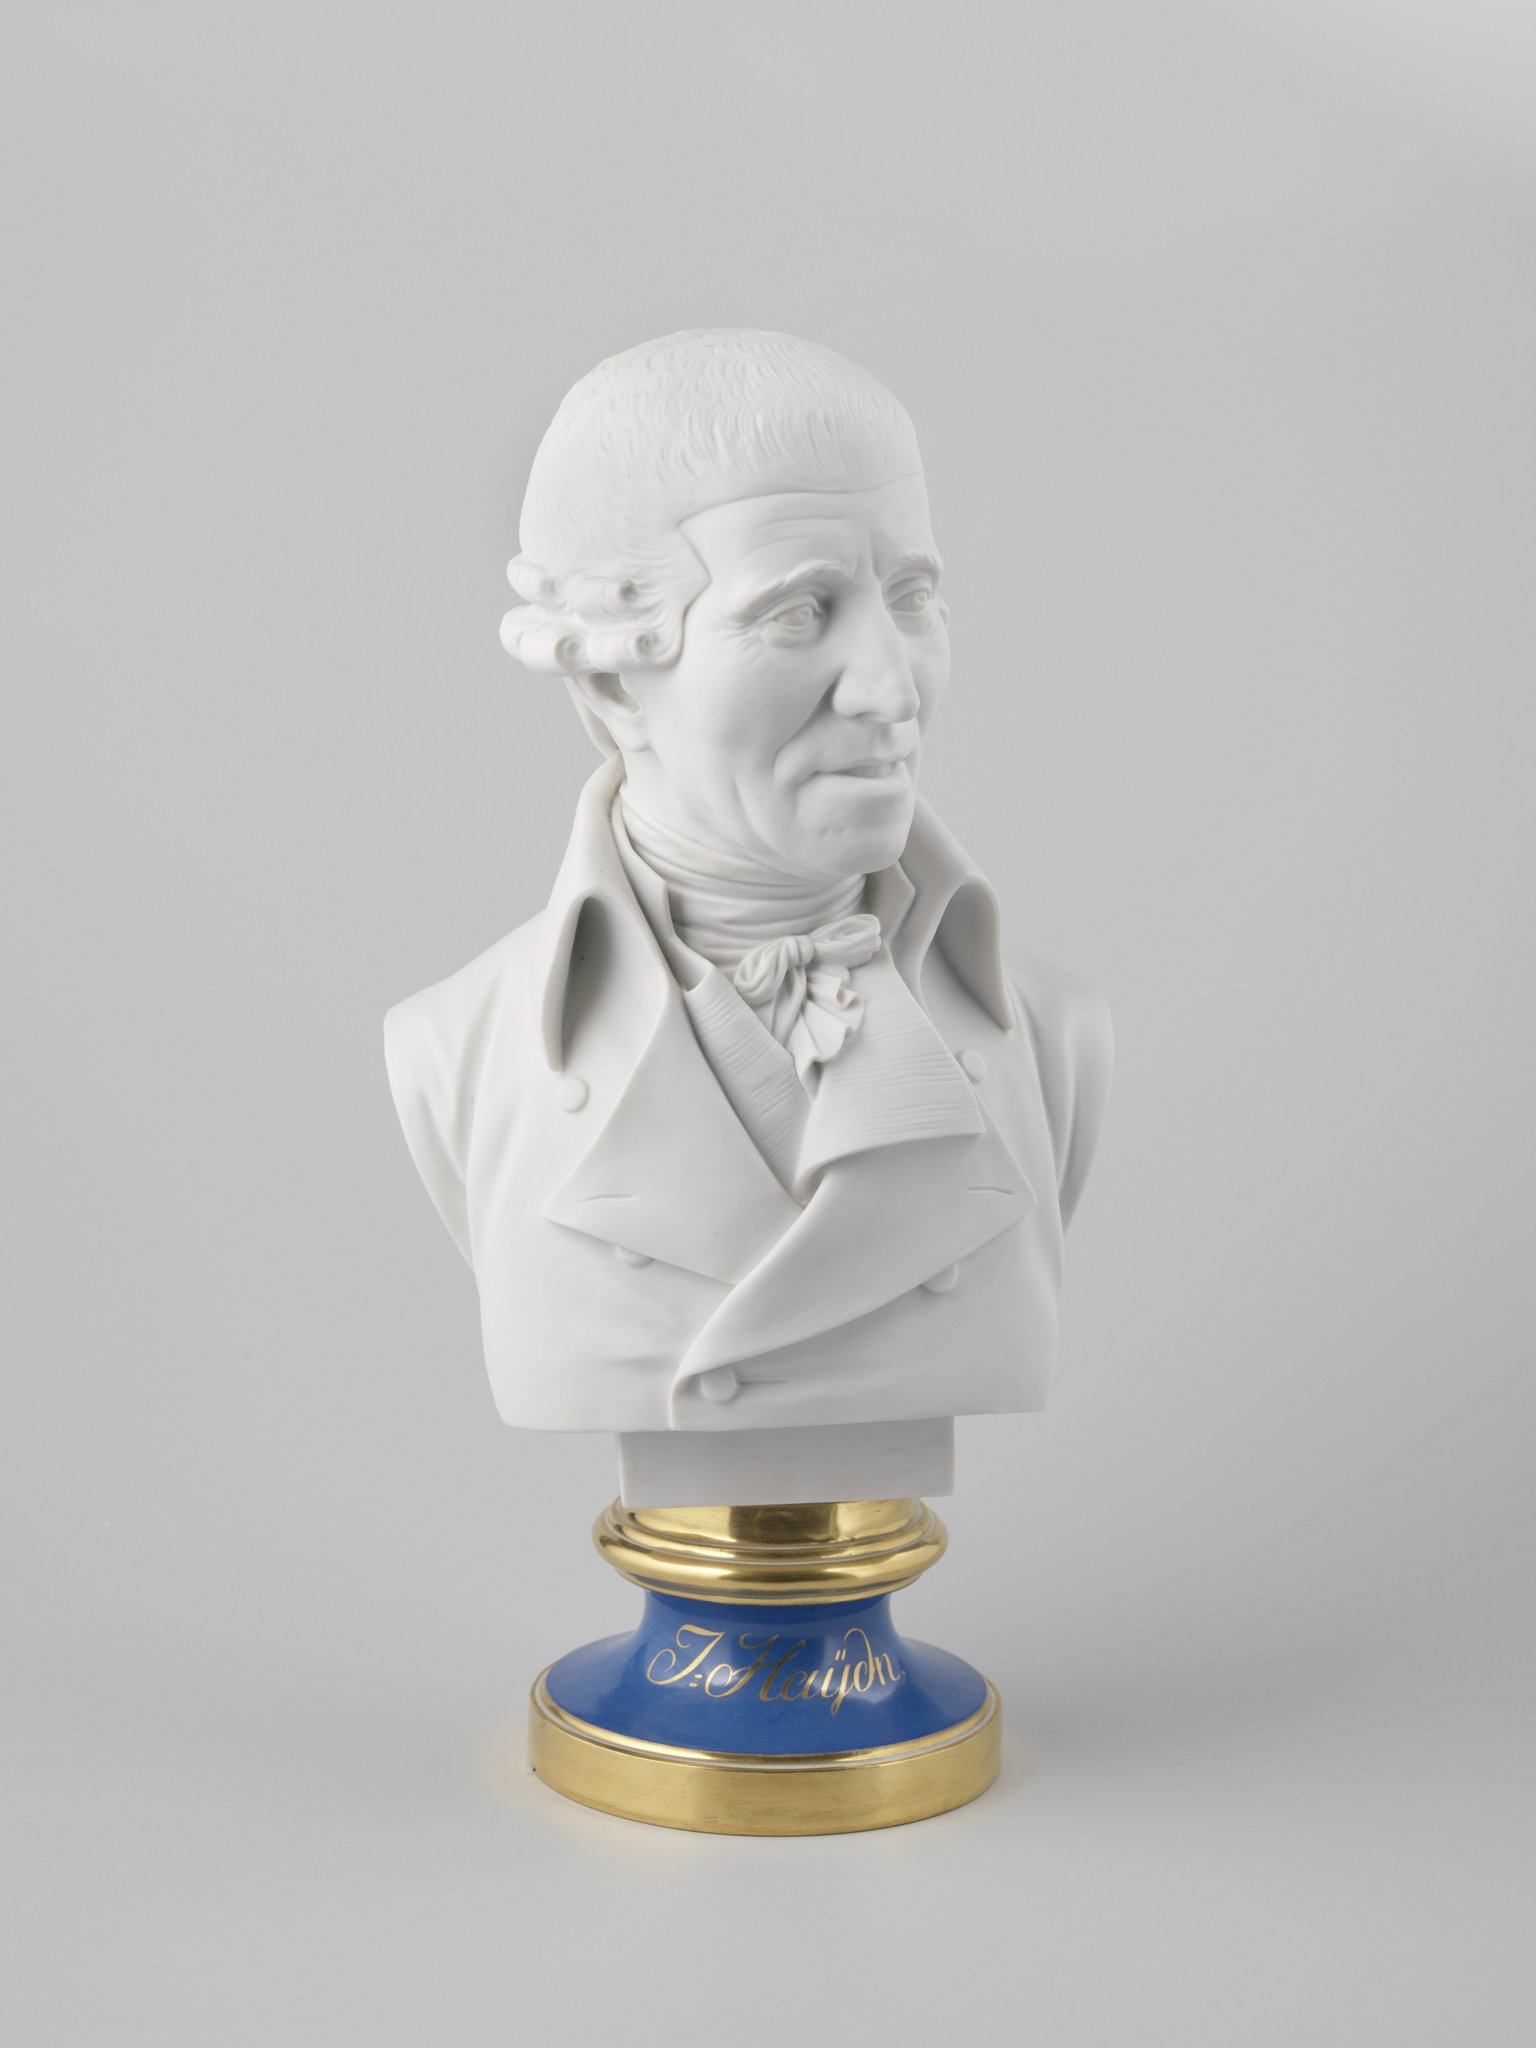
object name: bust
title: Portrait of Joseph Haydn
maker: anton grassi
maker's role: sculptor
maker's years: 1755-1807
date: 1805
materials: glaze, gold, paint, porcelain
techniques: firing, forming, gilding, vitrification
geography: vienna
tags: vienna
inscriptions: mark: ‘schild/ 59/ 805’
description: Bust on base of Joseph Haydn (1732 - 1809). Biscuit porcelain. Vienna, 1805. model by Anton Grassi.